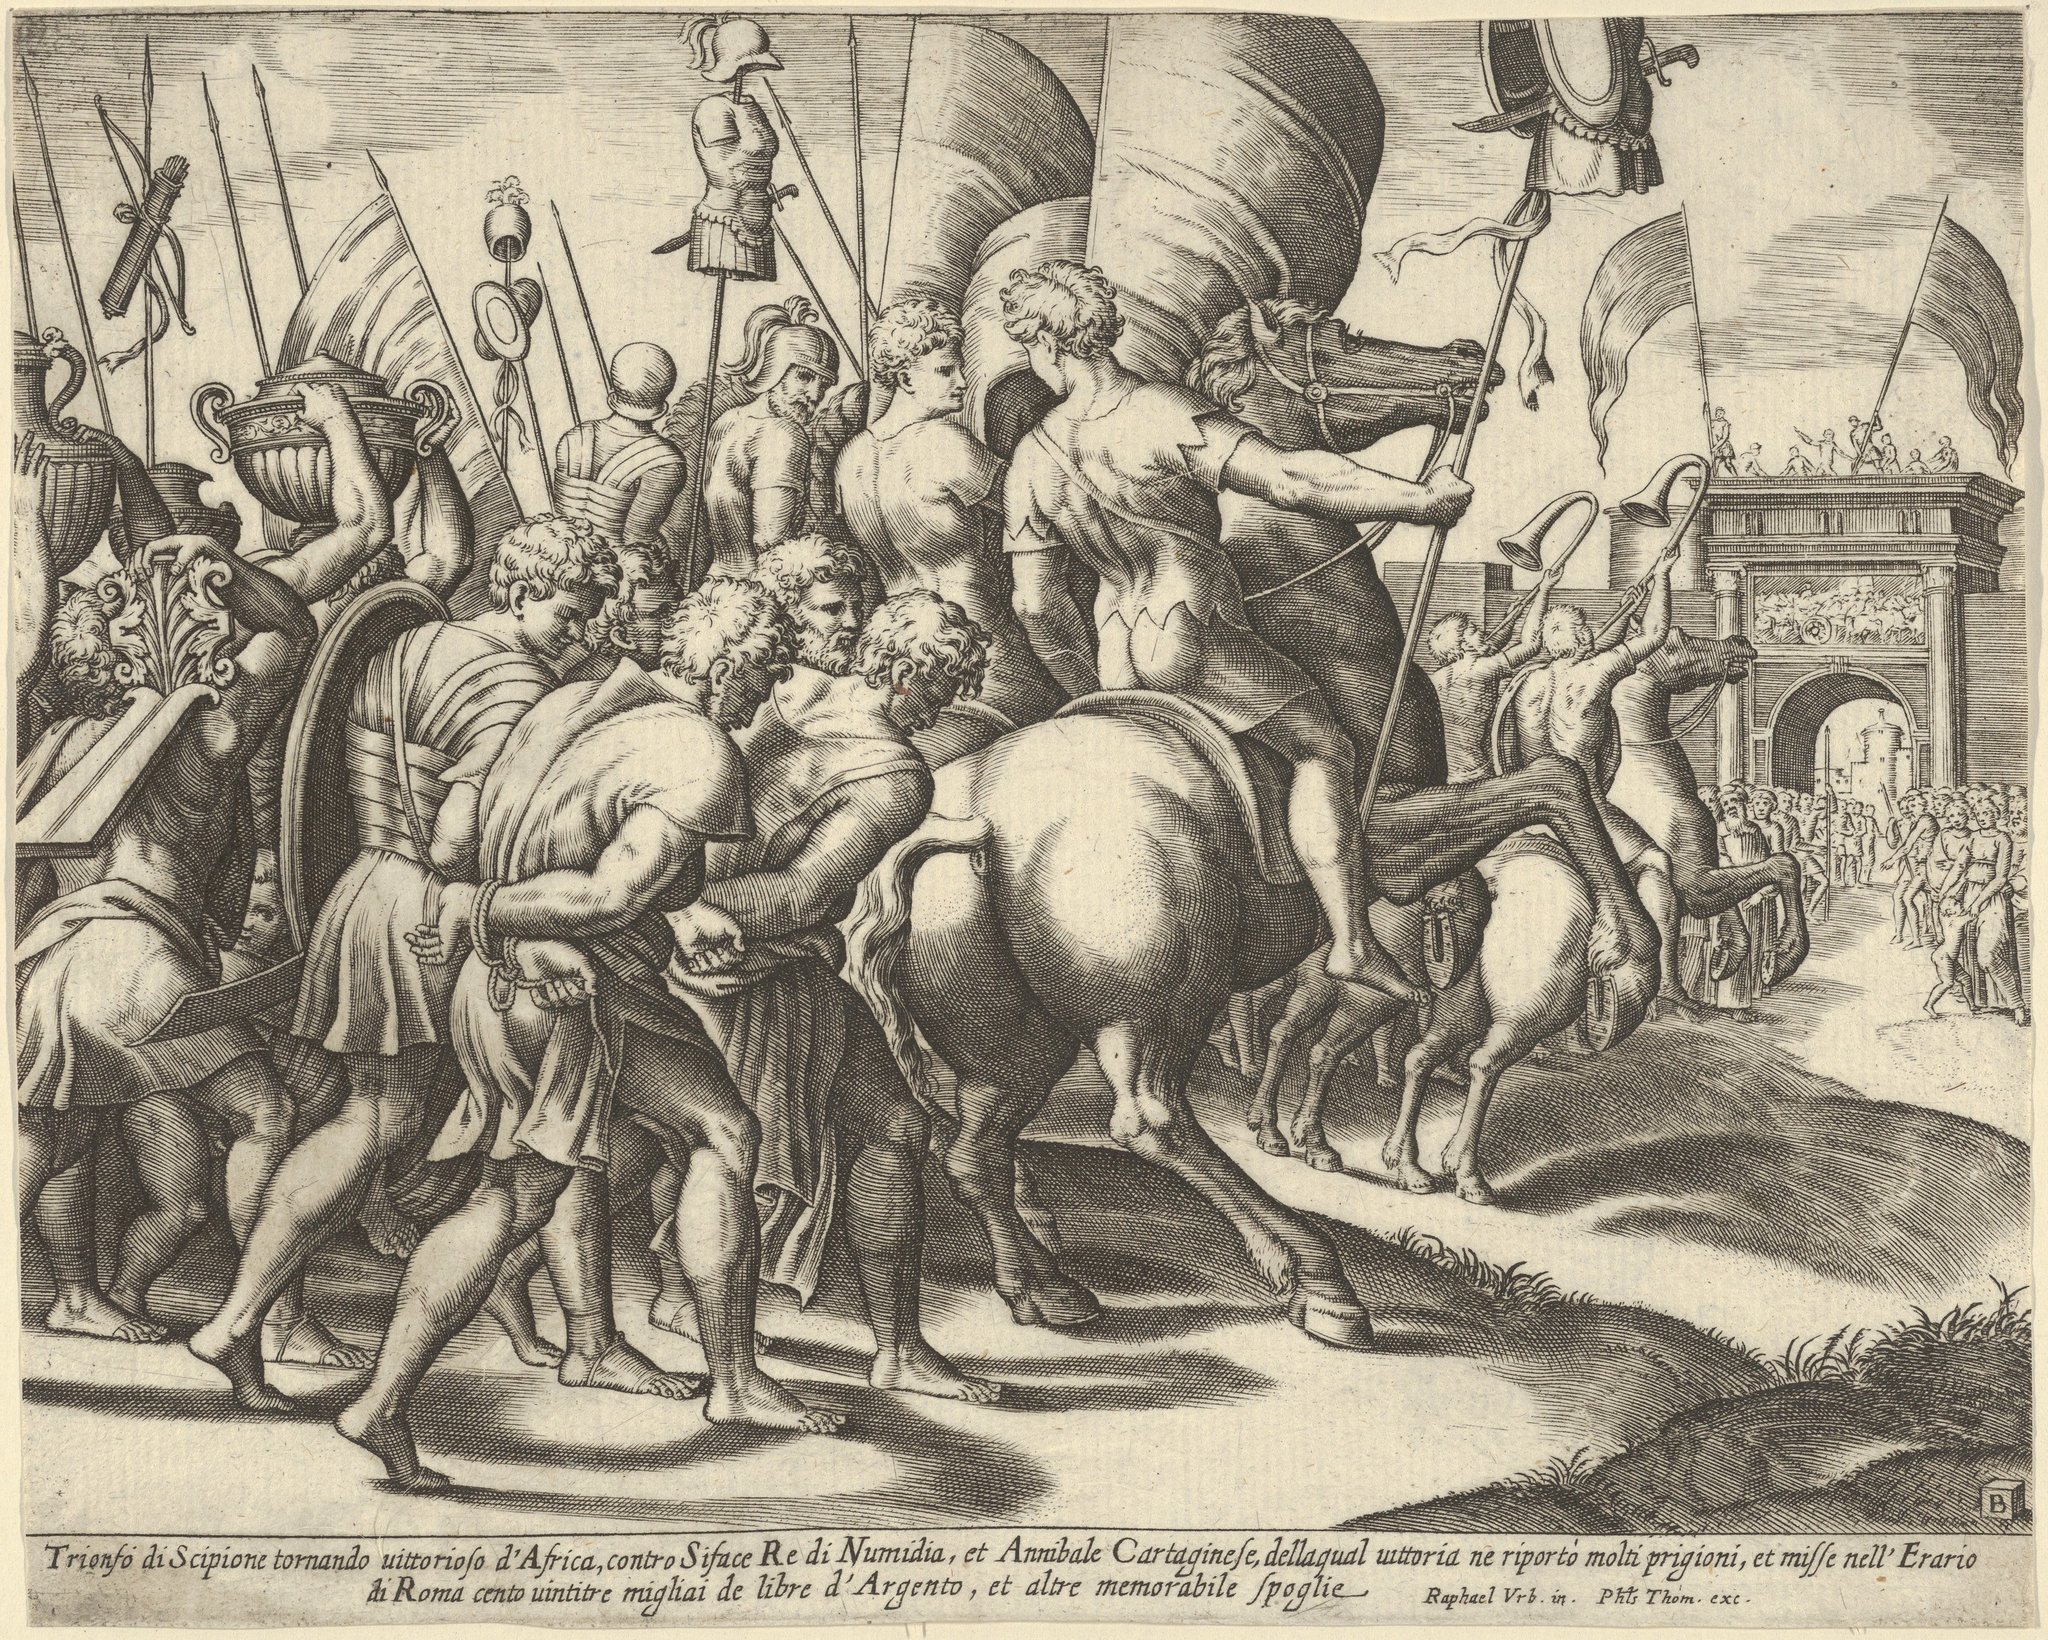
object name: print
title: The Triumph of Scipio who rides on a horse followed by captured slaves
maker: master of the die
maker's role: artist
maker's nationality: italian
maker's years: 1525-1560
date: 1530-1560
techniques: engraving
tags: gates,soldiers,men